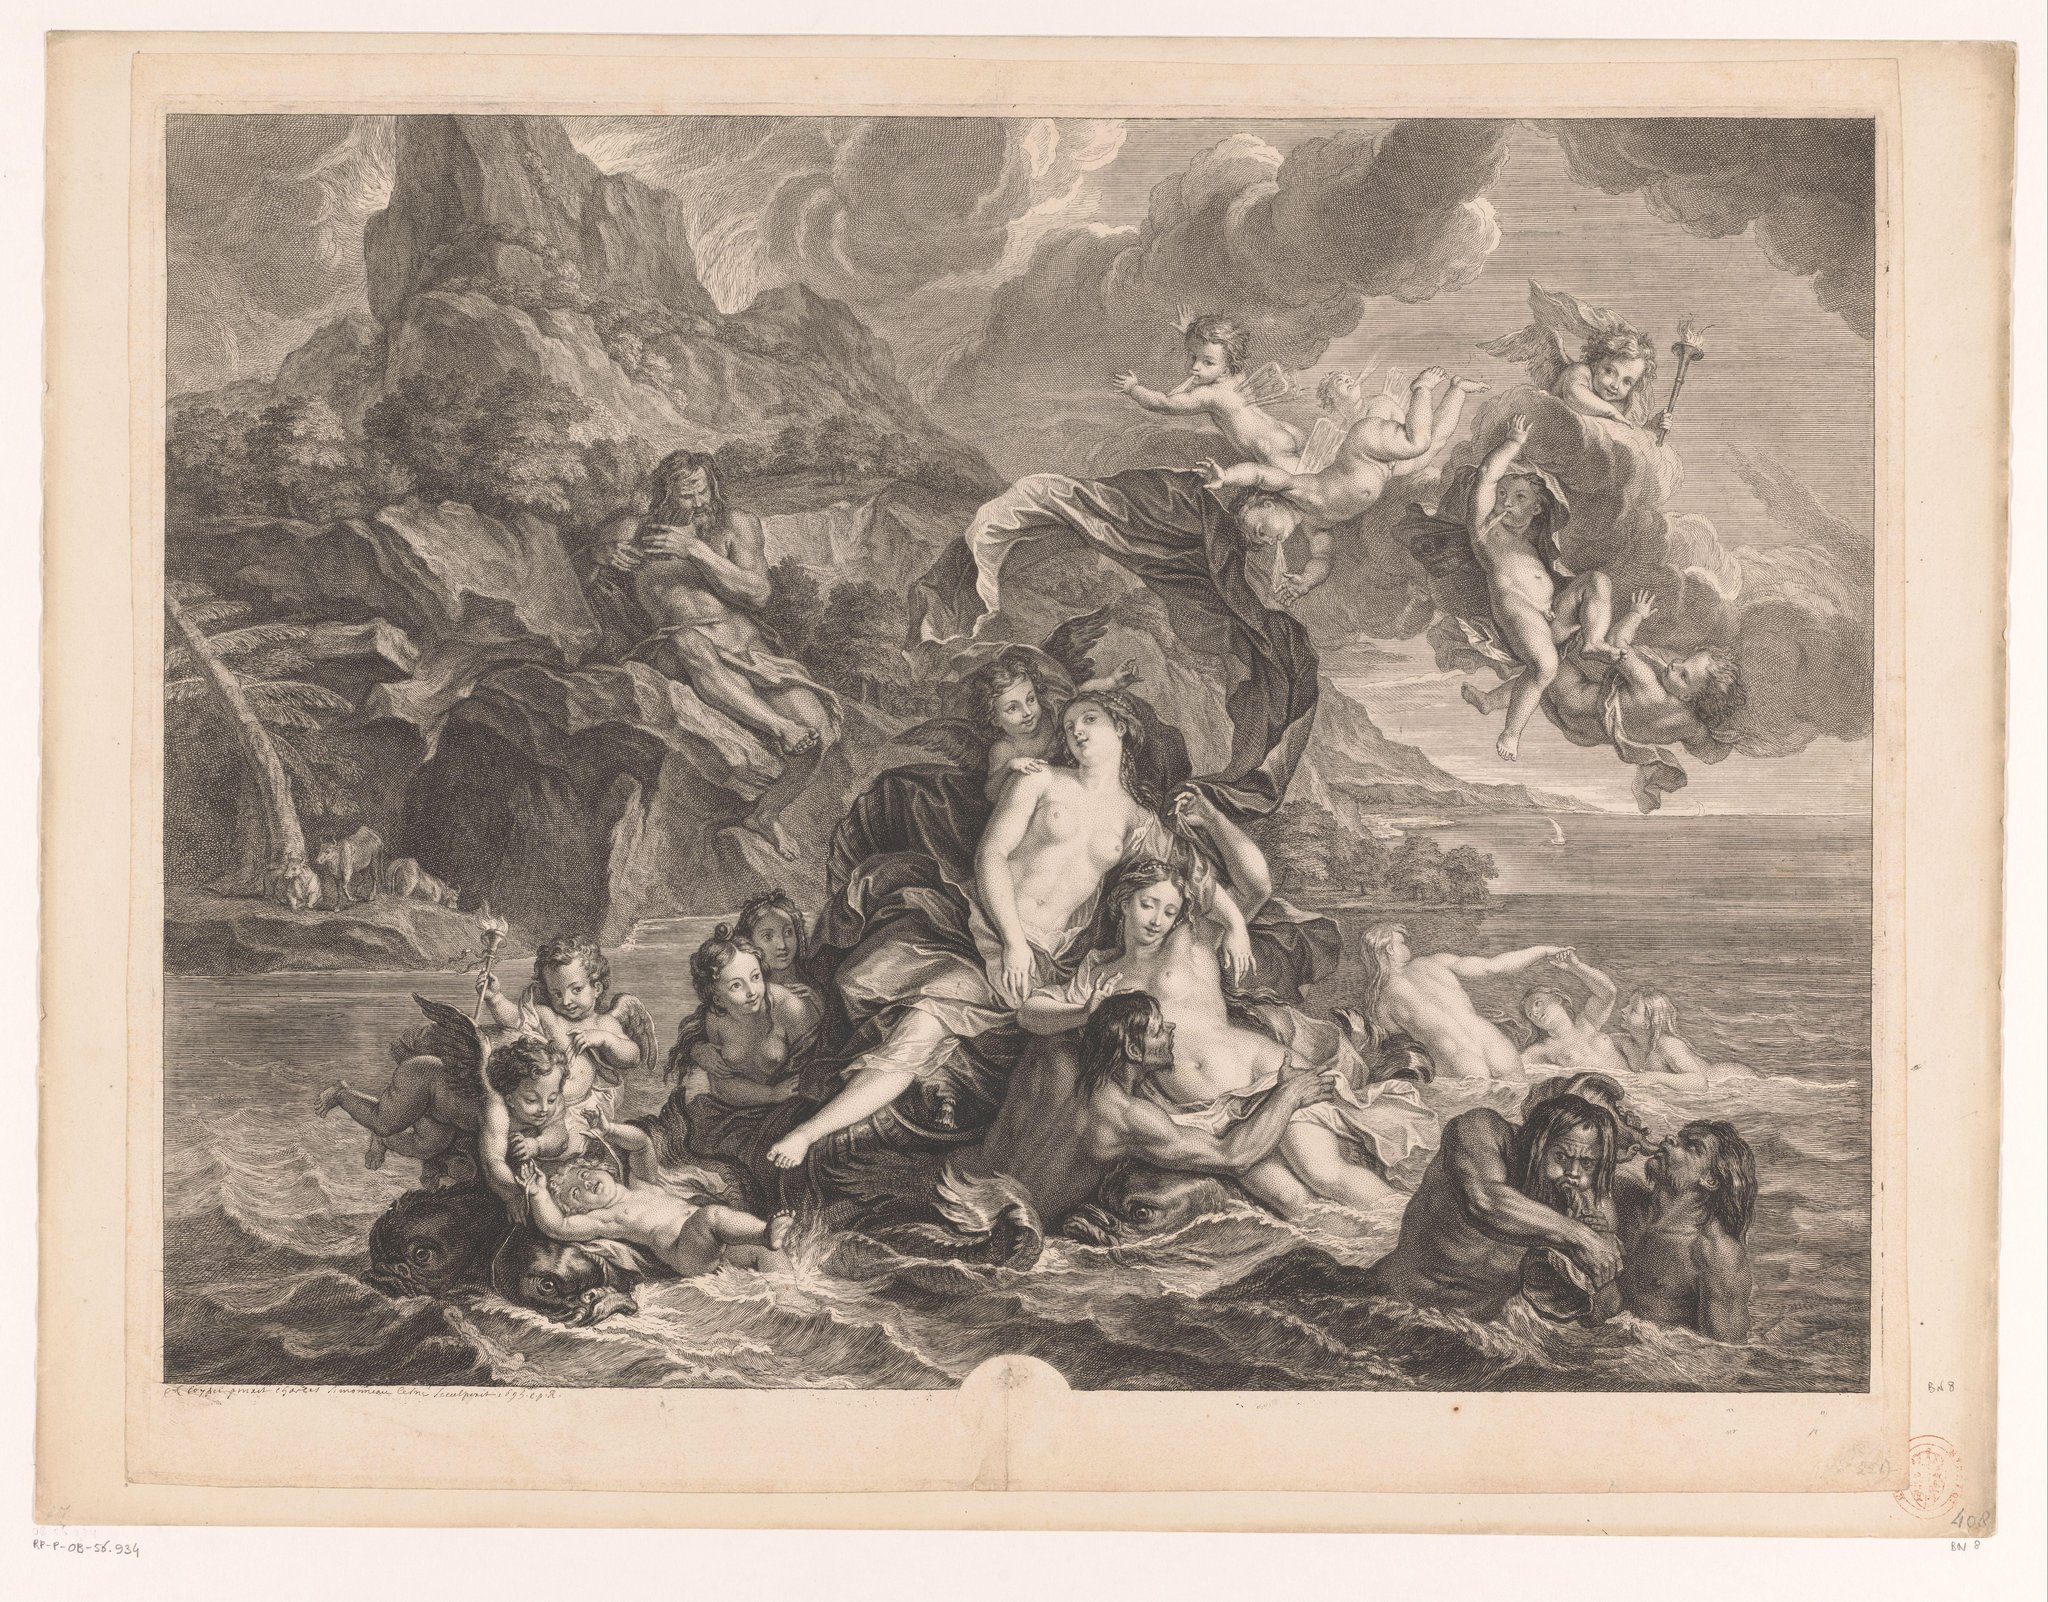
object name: print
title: Triomf van Galatea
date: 1695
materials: paper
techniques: engraving, etching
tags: triumph of galatea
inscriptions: collector's mark: Lugt 240